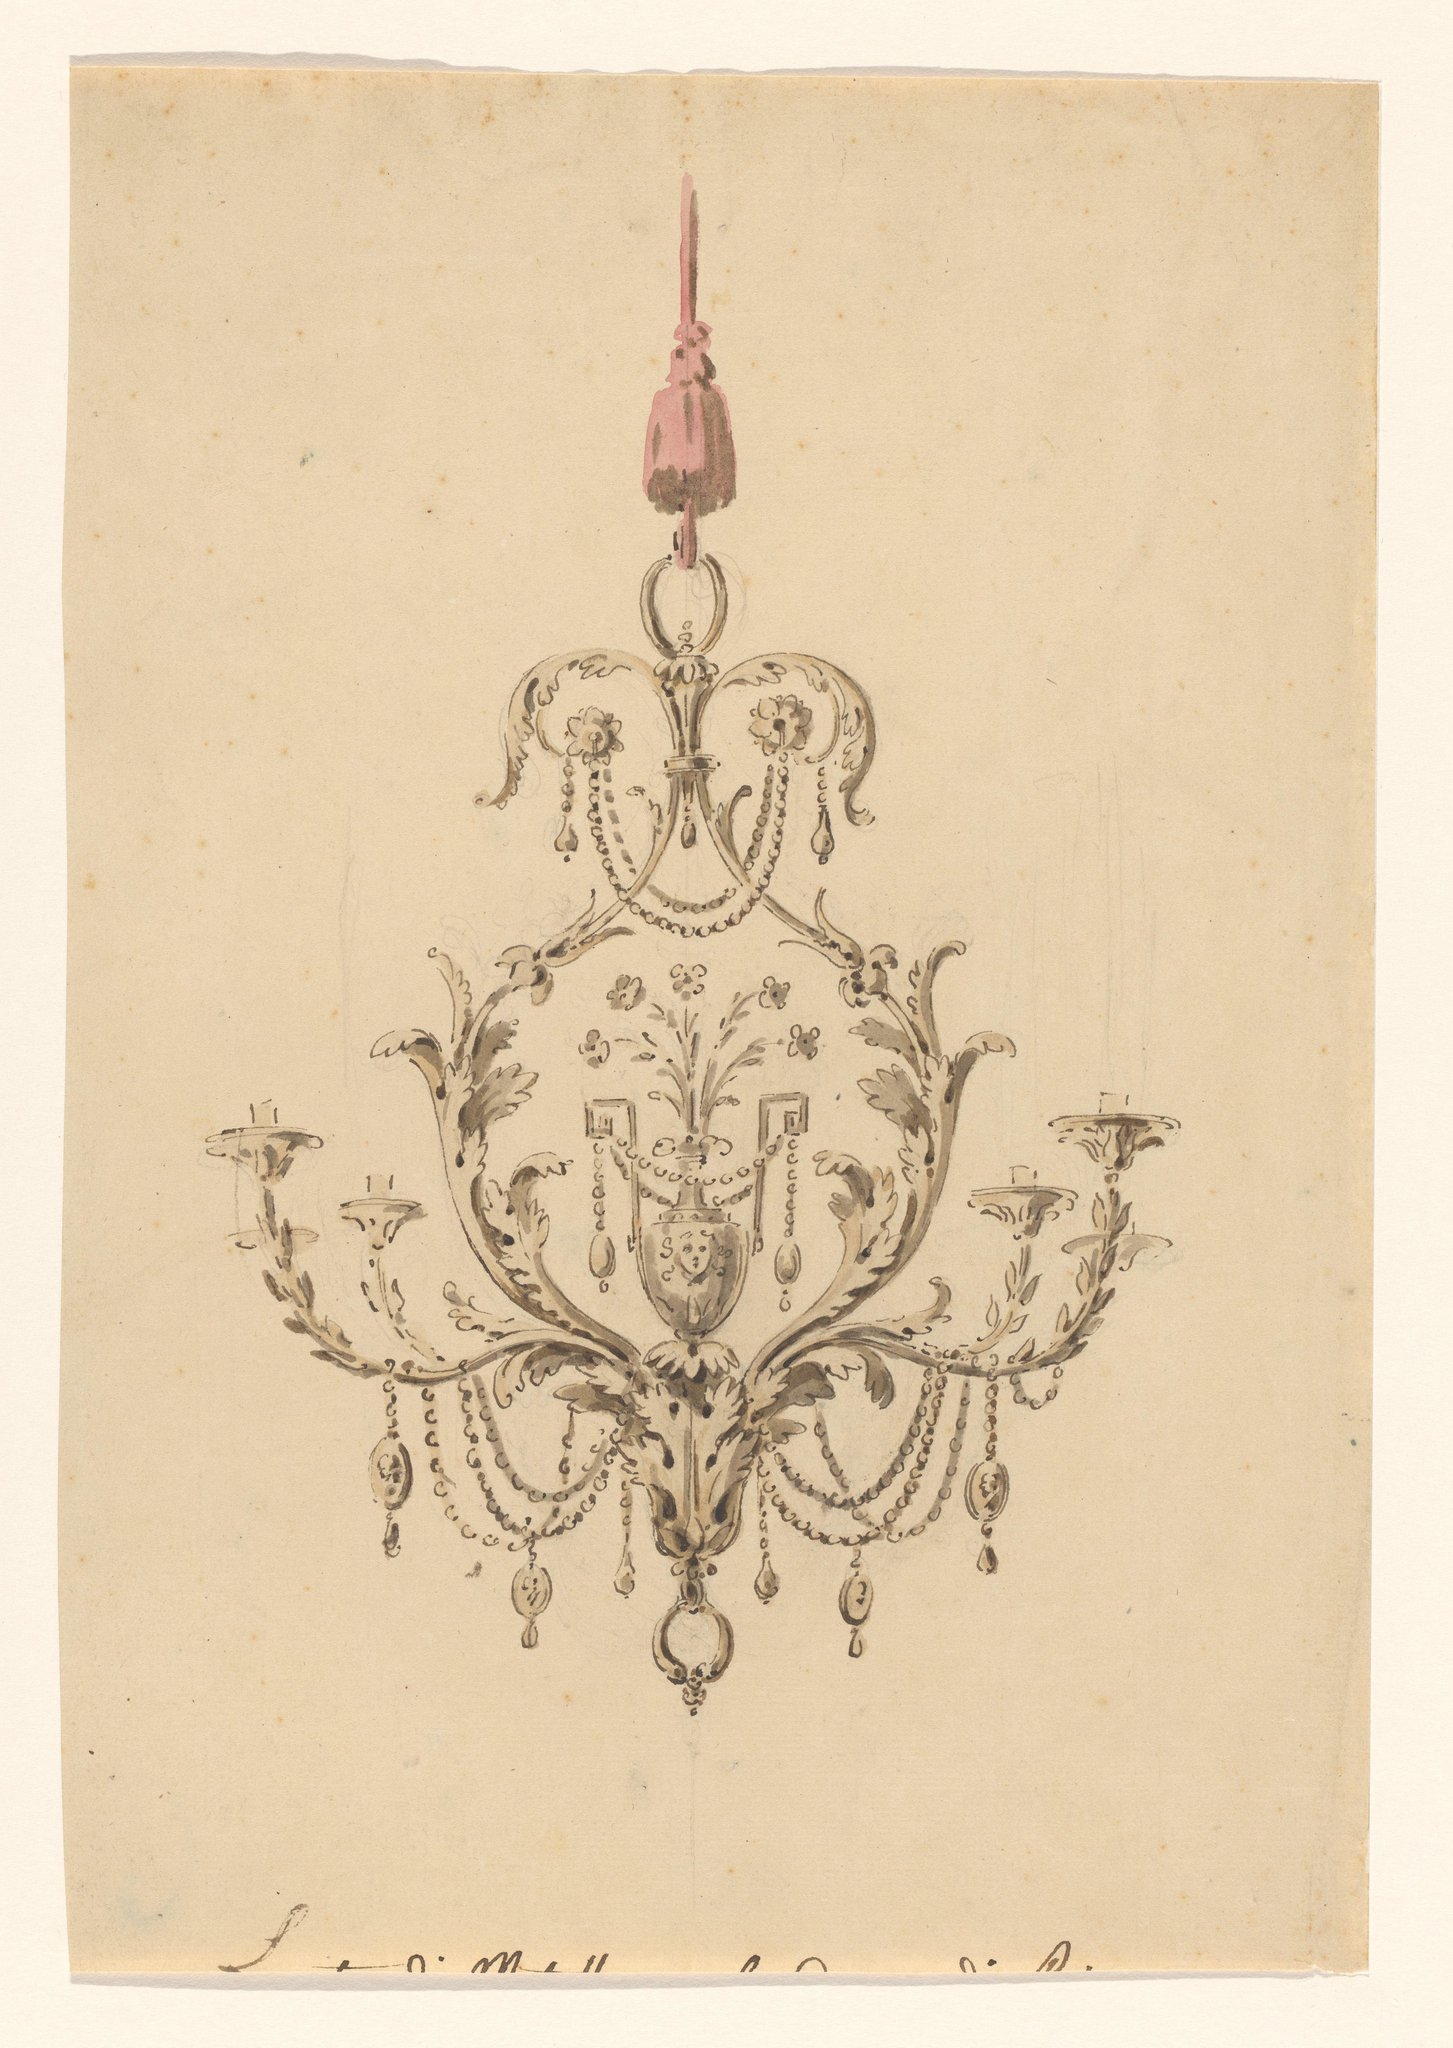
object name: drawing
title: Ontwerp voor een lichtkroon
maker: Anonymous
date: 1780-1790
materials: chalk, ink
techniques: drawing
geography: paris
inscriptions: collector's mark: ‘Ovaal verzamelaarsmerk Col. L. BONGARD’, inscription: ‘Wellicht: Lustre en Metalle […]’